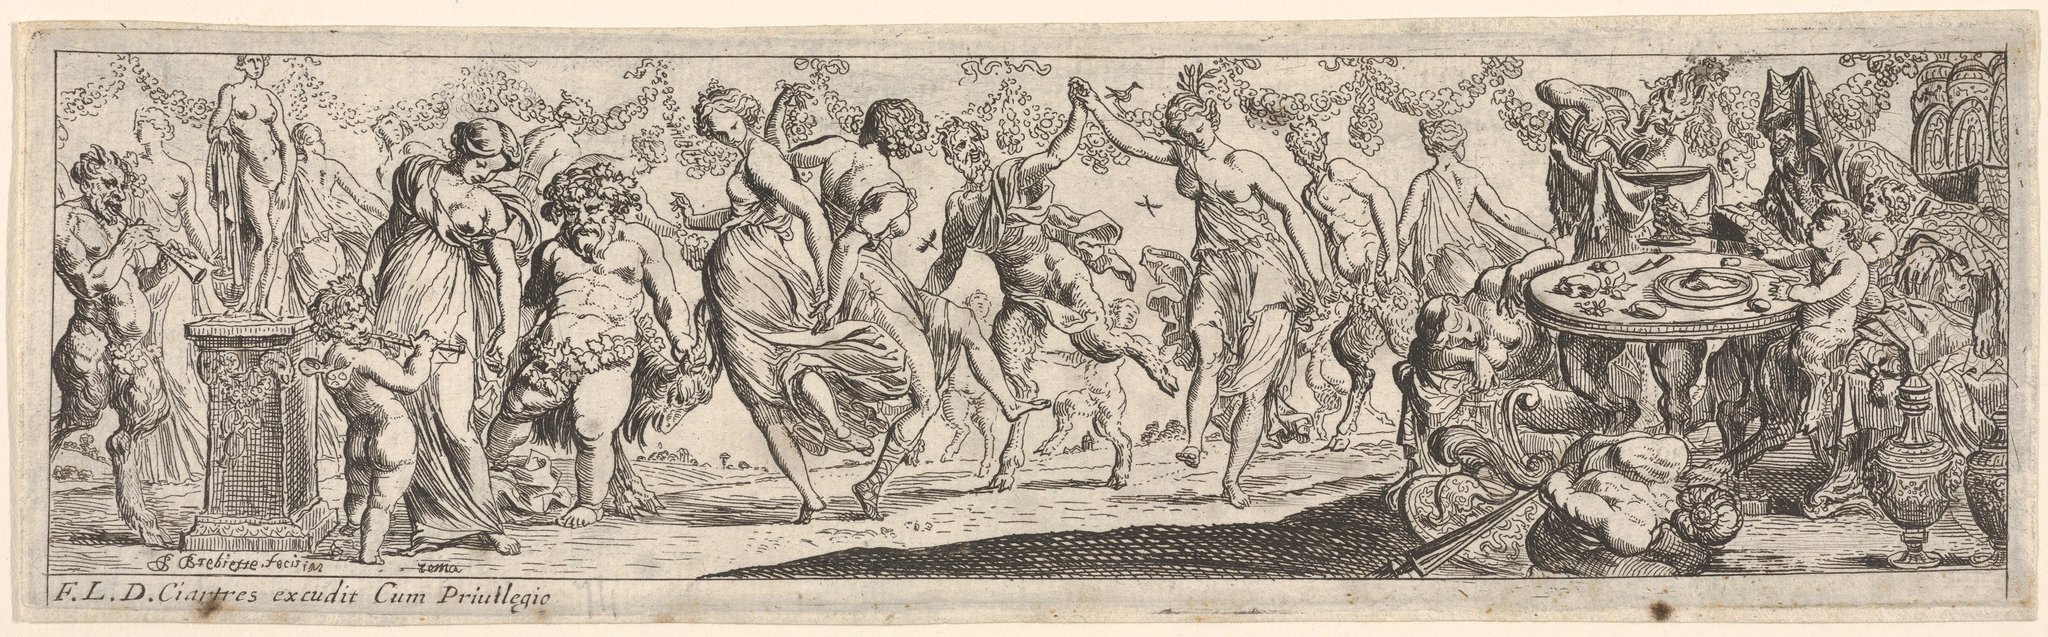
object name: print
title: Plate 5 from "Les Grandes Frises"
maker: pierre brebiette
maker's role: artist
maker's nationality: french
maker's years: 1598-1642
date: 1626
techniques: etching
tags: men,women,dancing,satyrs